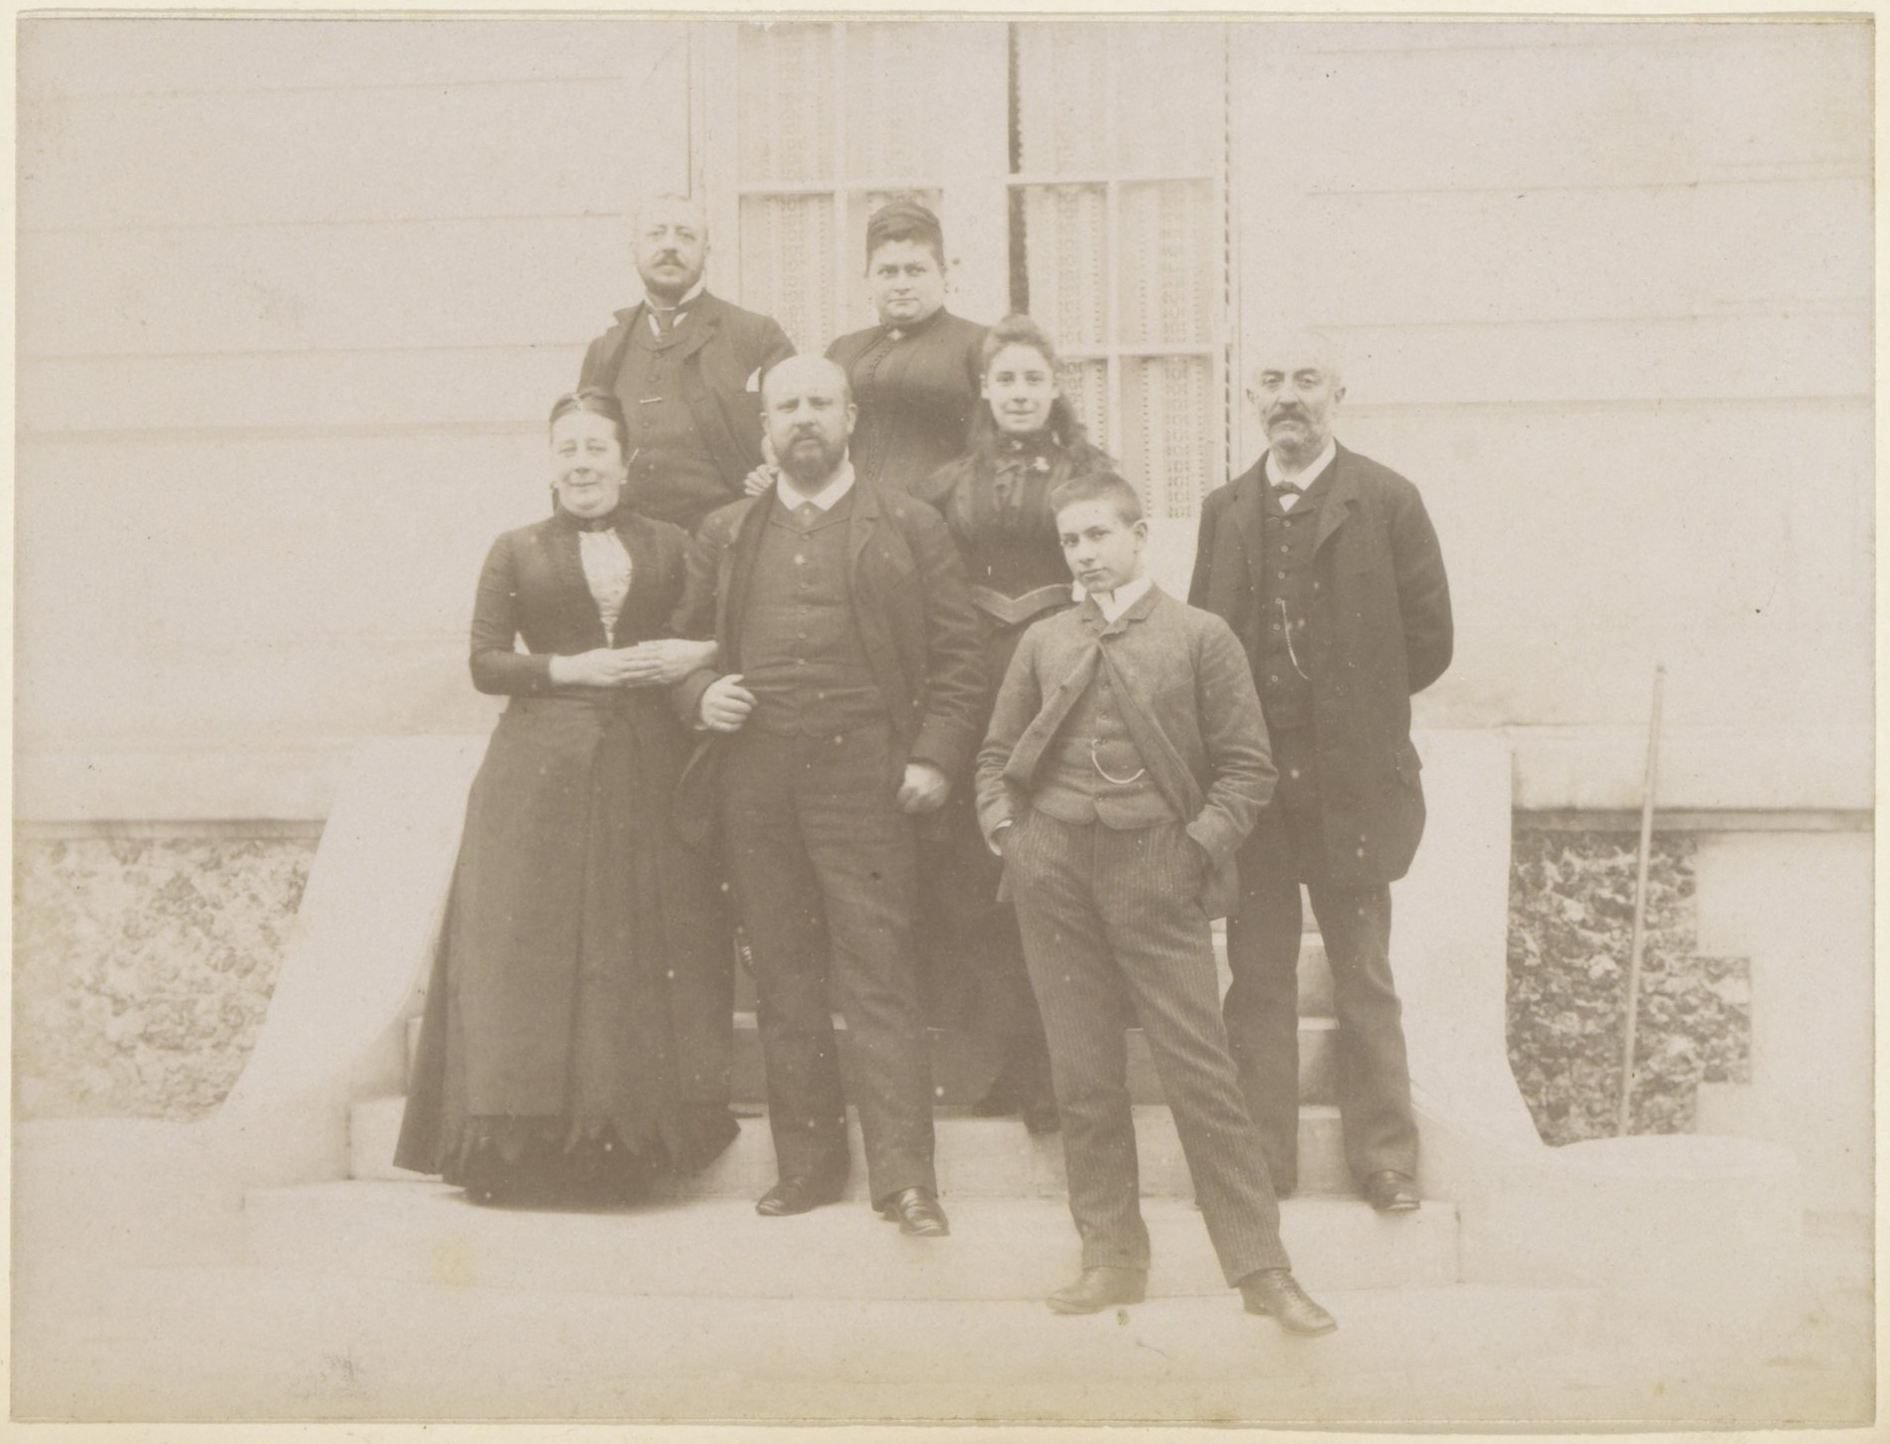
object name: photograph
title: Groepsportret van een Franse familie op de trappen voor een huis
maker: Anonymous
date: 1900-1910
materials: paper, photographic support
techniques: albumen print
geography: france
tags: three generations (family group), france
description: Onderdeel van Fotoalbum van een Franse amateurfotograaf met opnames van een familie, distilleerderij Delizy & Doistau Fils, het leger en bezienswaardigheden in Frankrijk.